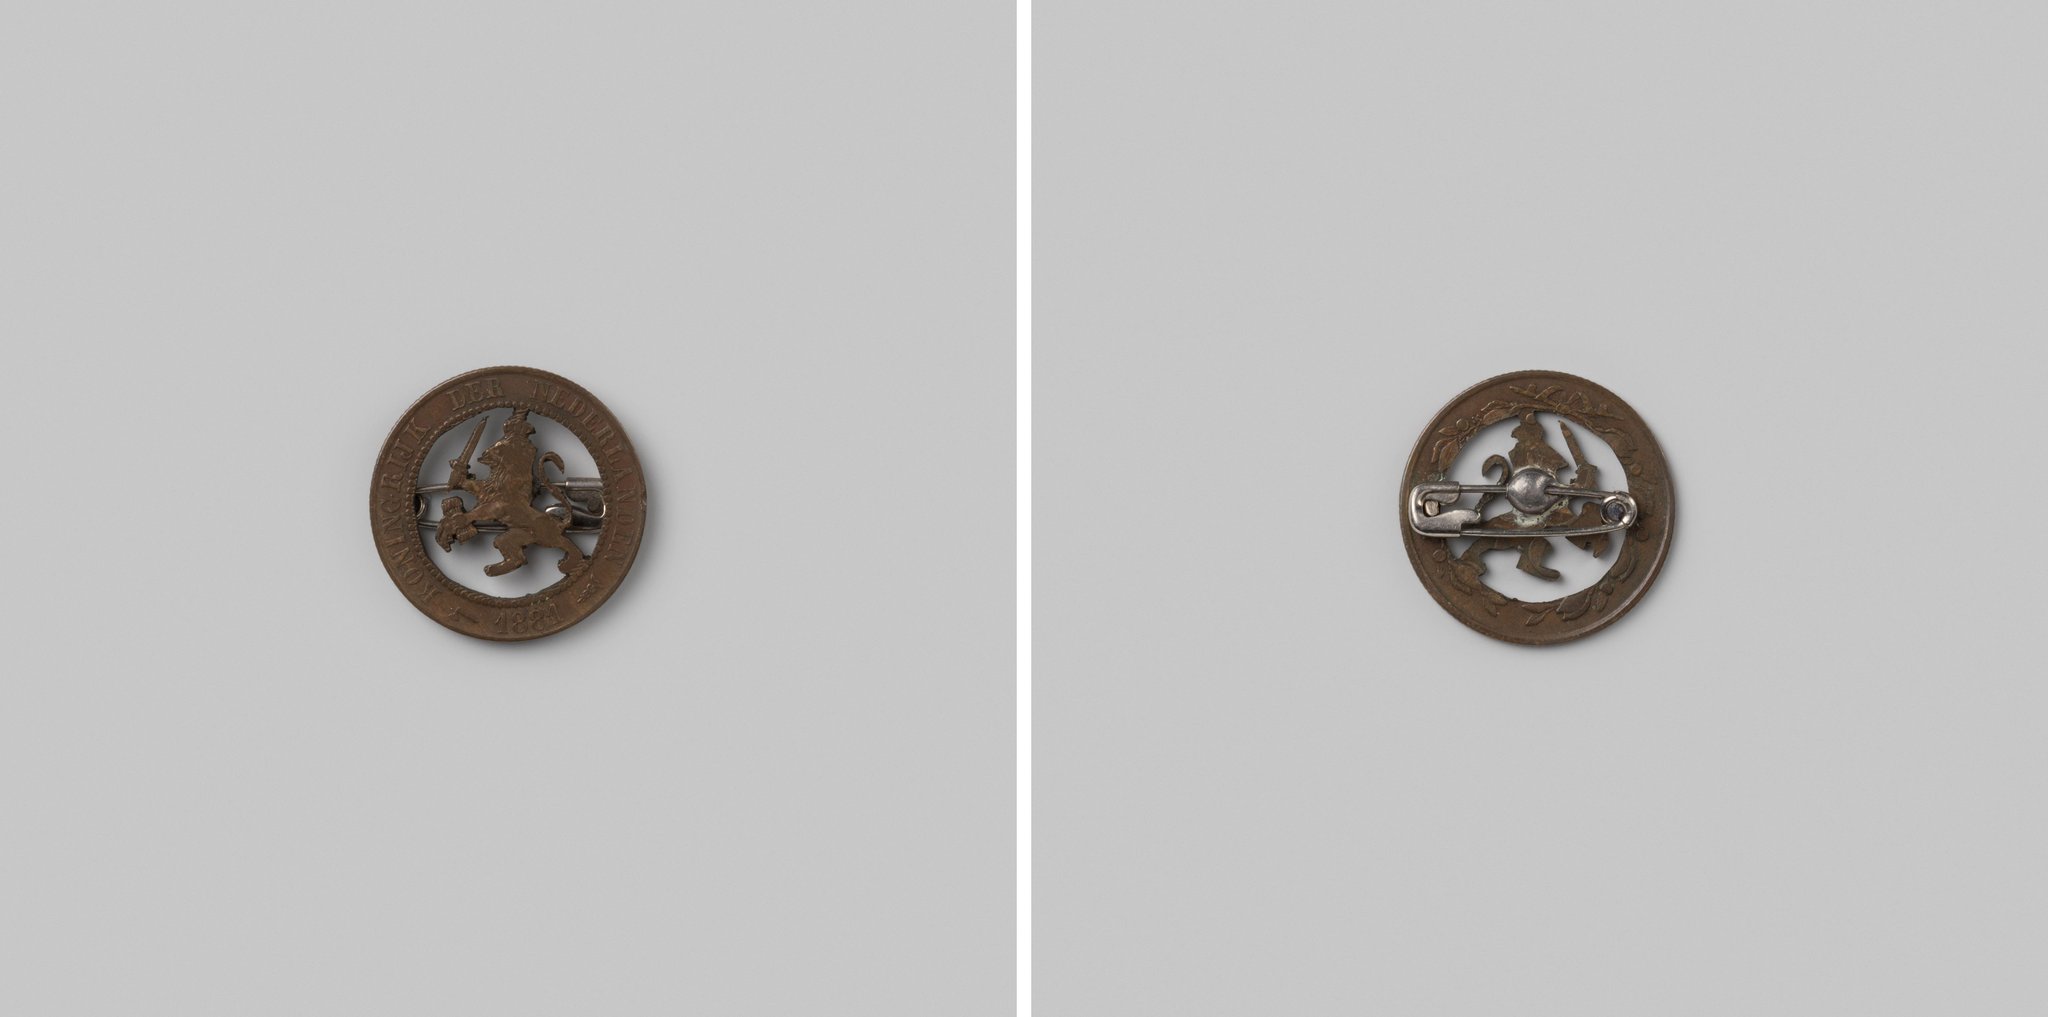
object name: twee en een halve cent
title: Willem III, koning der Nederlanden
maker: Anonymous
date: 1881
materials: bronze, metal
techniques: soldering, striking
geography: utrecht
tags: brussels, willem iii (koning der nederlanden), netherlands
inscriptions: inscription: ‘KONINGRIJK DER NEDERLANDEN 1881’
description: Bronzen insigne, vervaardigd uit ajour bewerkte munt van twee-en een halve cent, waarvan alleen beeldenaar en rand zijn overgelaten; hieraan is aan achterzijde veiligheidsspeld gesoldeerd. Voorzijde: gekroonde leeuw met zwaard en pijlenbundel binnen parelrand en omschrift. Keerzijde: gedeelte van voorstelling op oorspronkelijke munt zichtbaar.